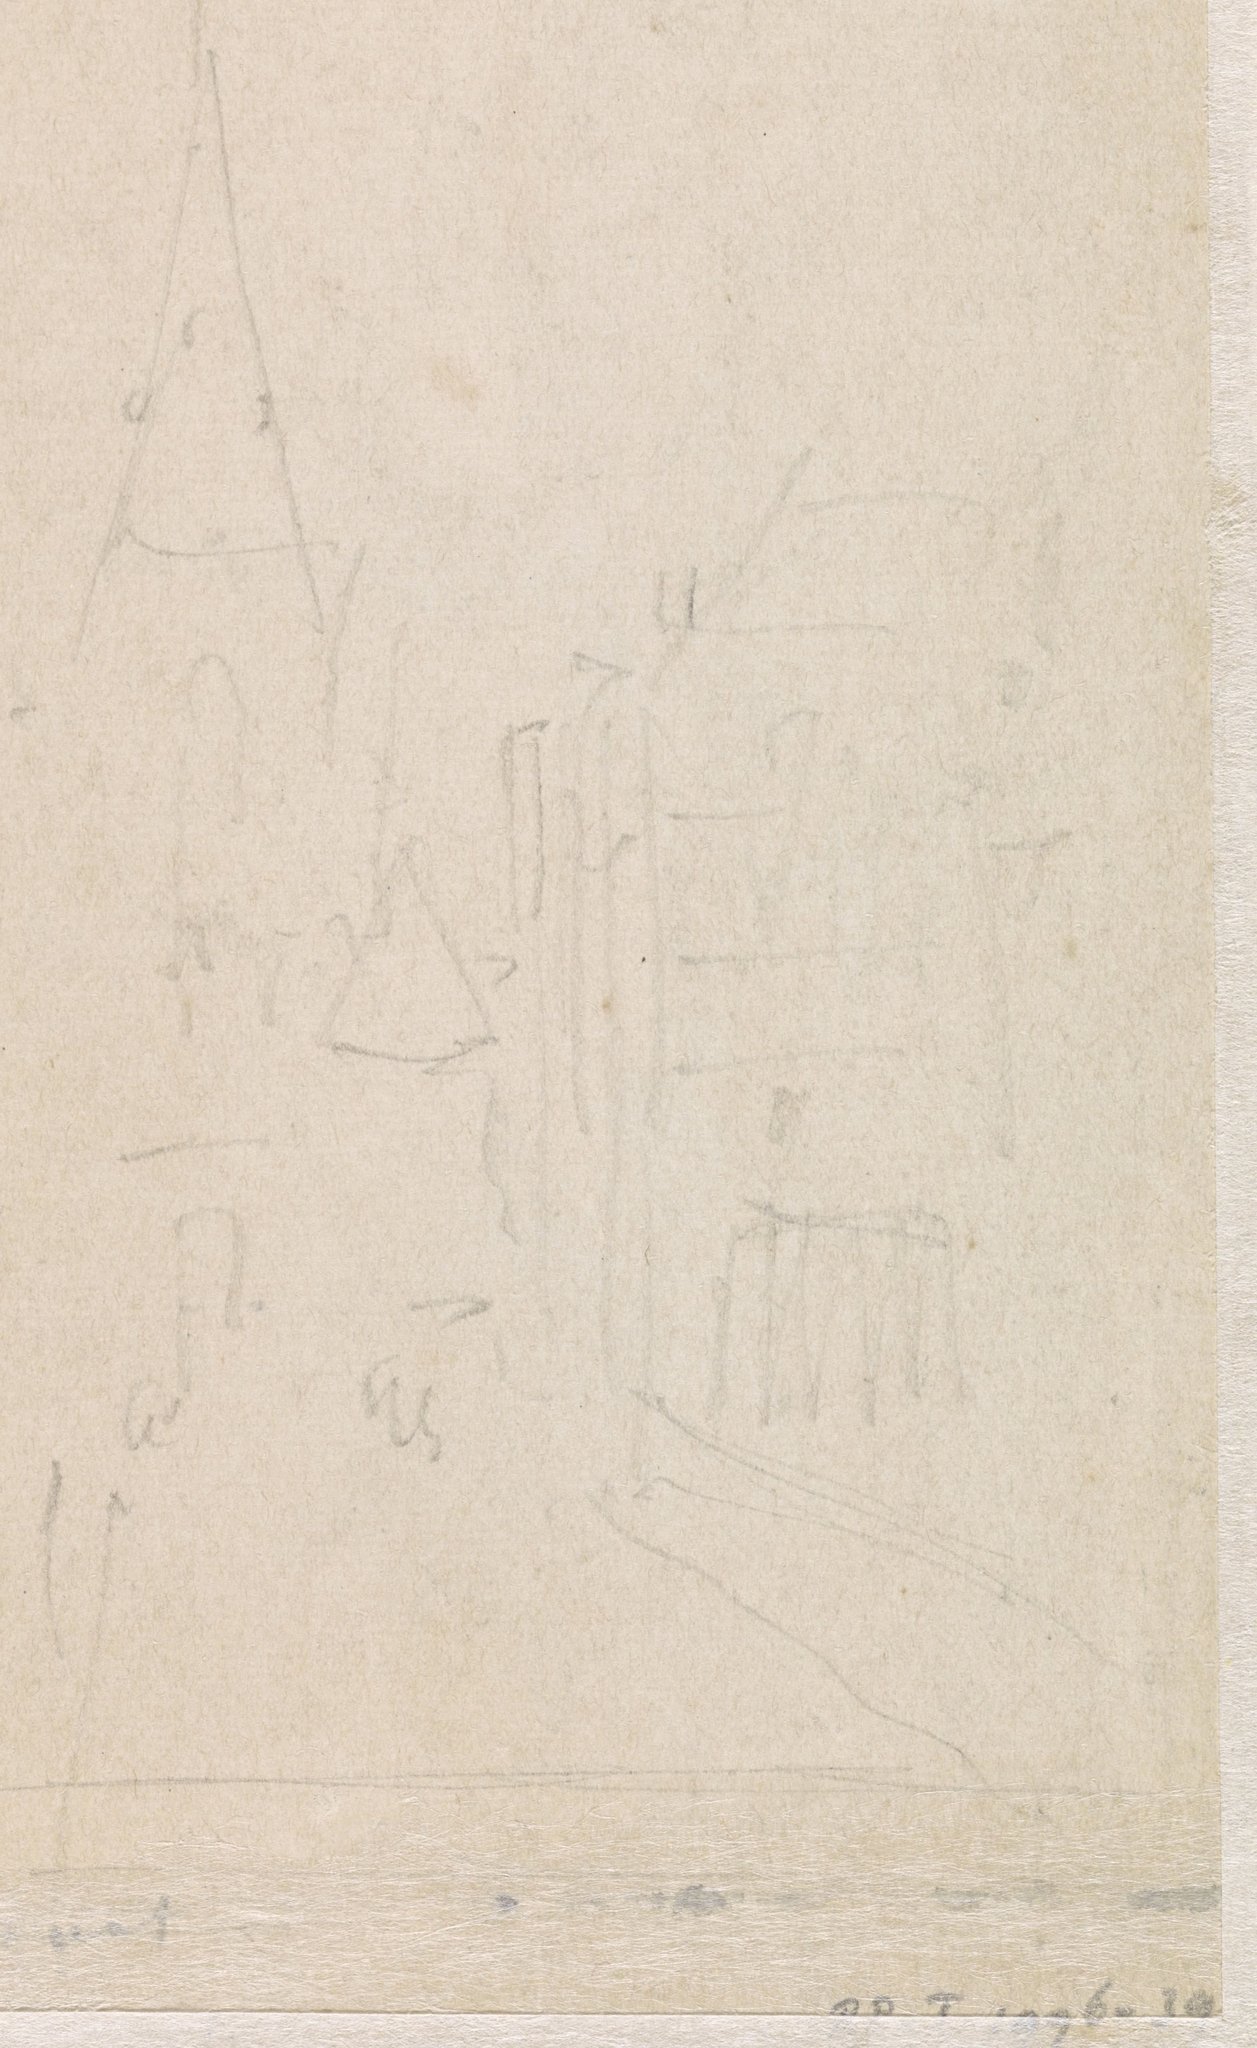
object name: drawing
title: Schets van een stadsgezicht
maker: adrianus eversen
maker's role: draughtsman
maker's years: 1818-1897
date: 1828-1897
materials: paper, pencil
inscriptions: inscription: ‘V.V. Straat (? RJtR)’